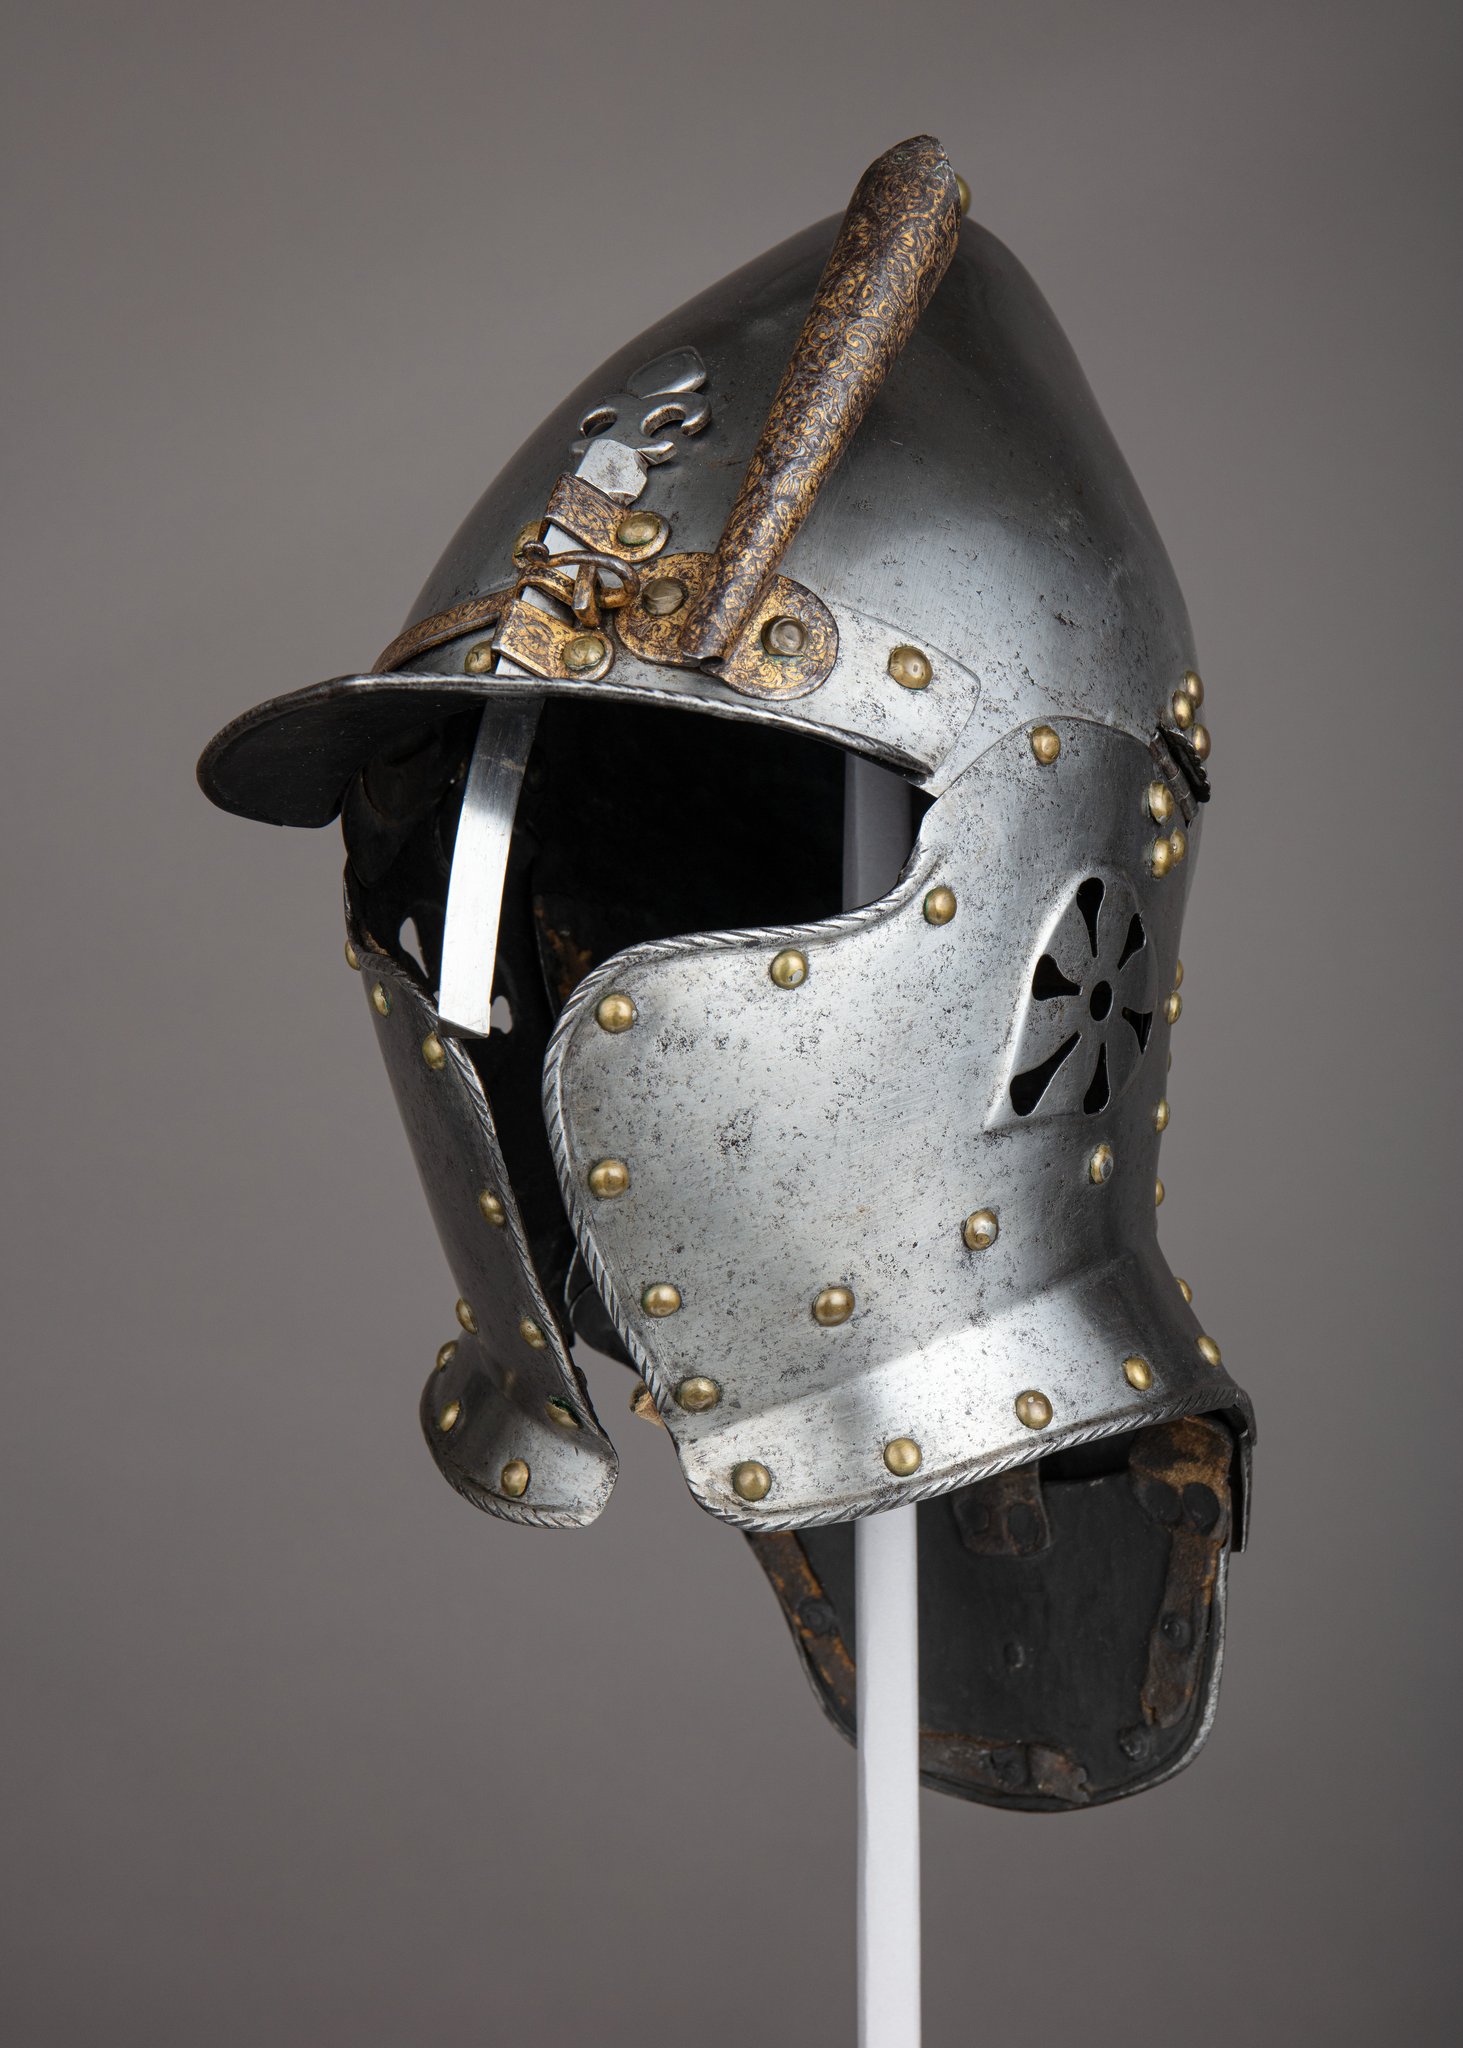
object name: lobster tail burgonet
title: Lobster-Tail Burgonet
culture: german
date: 1501-1600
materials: brass, gold, leather, steel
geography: germany